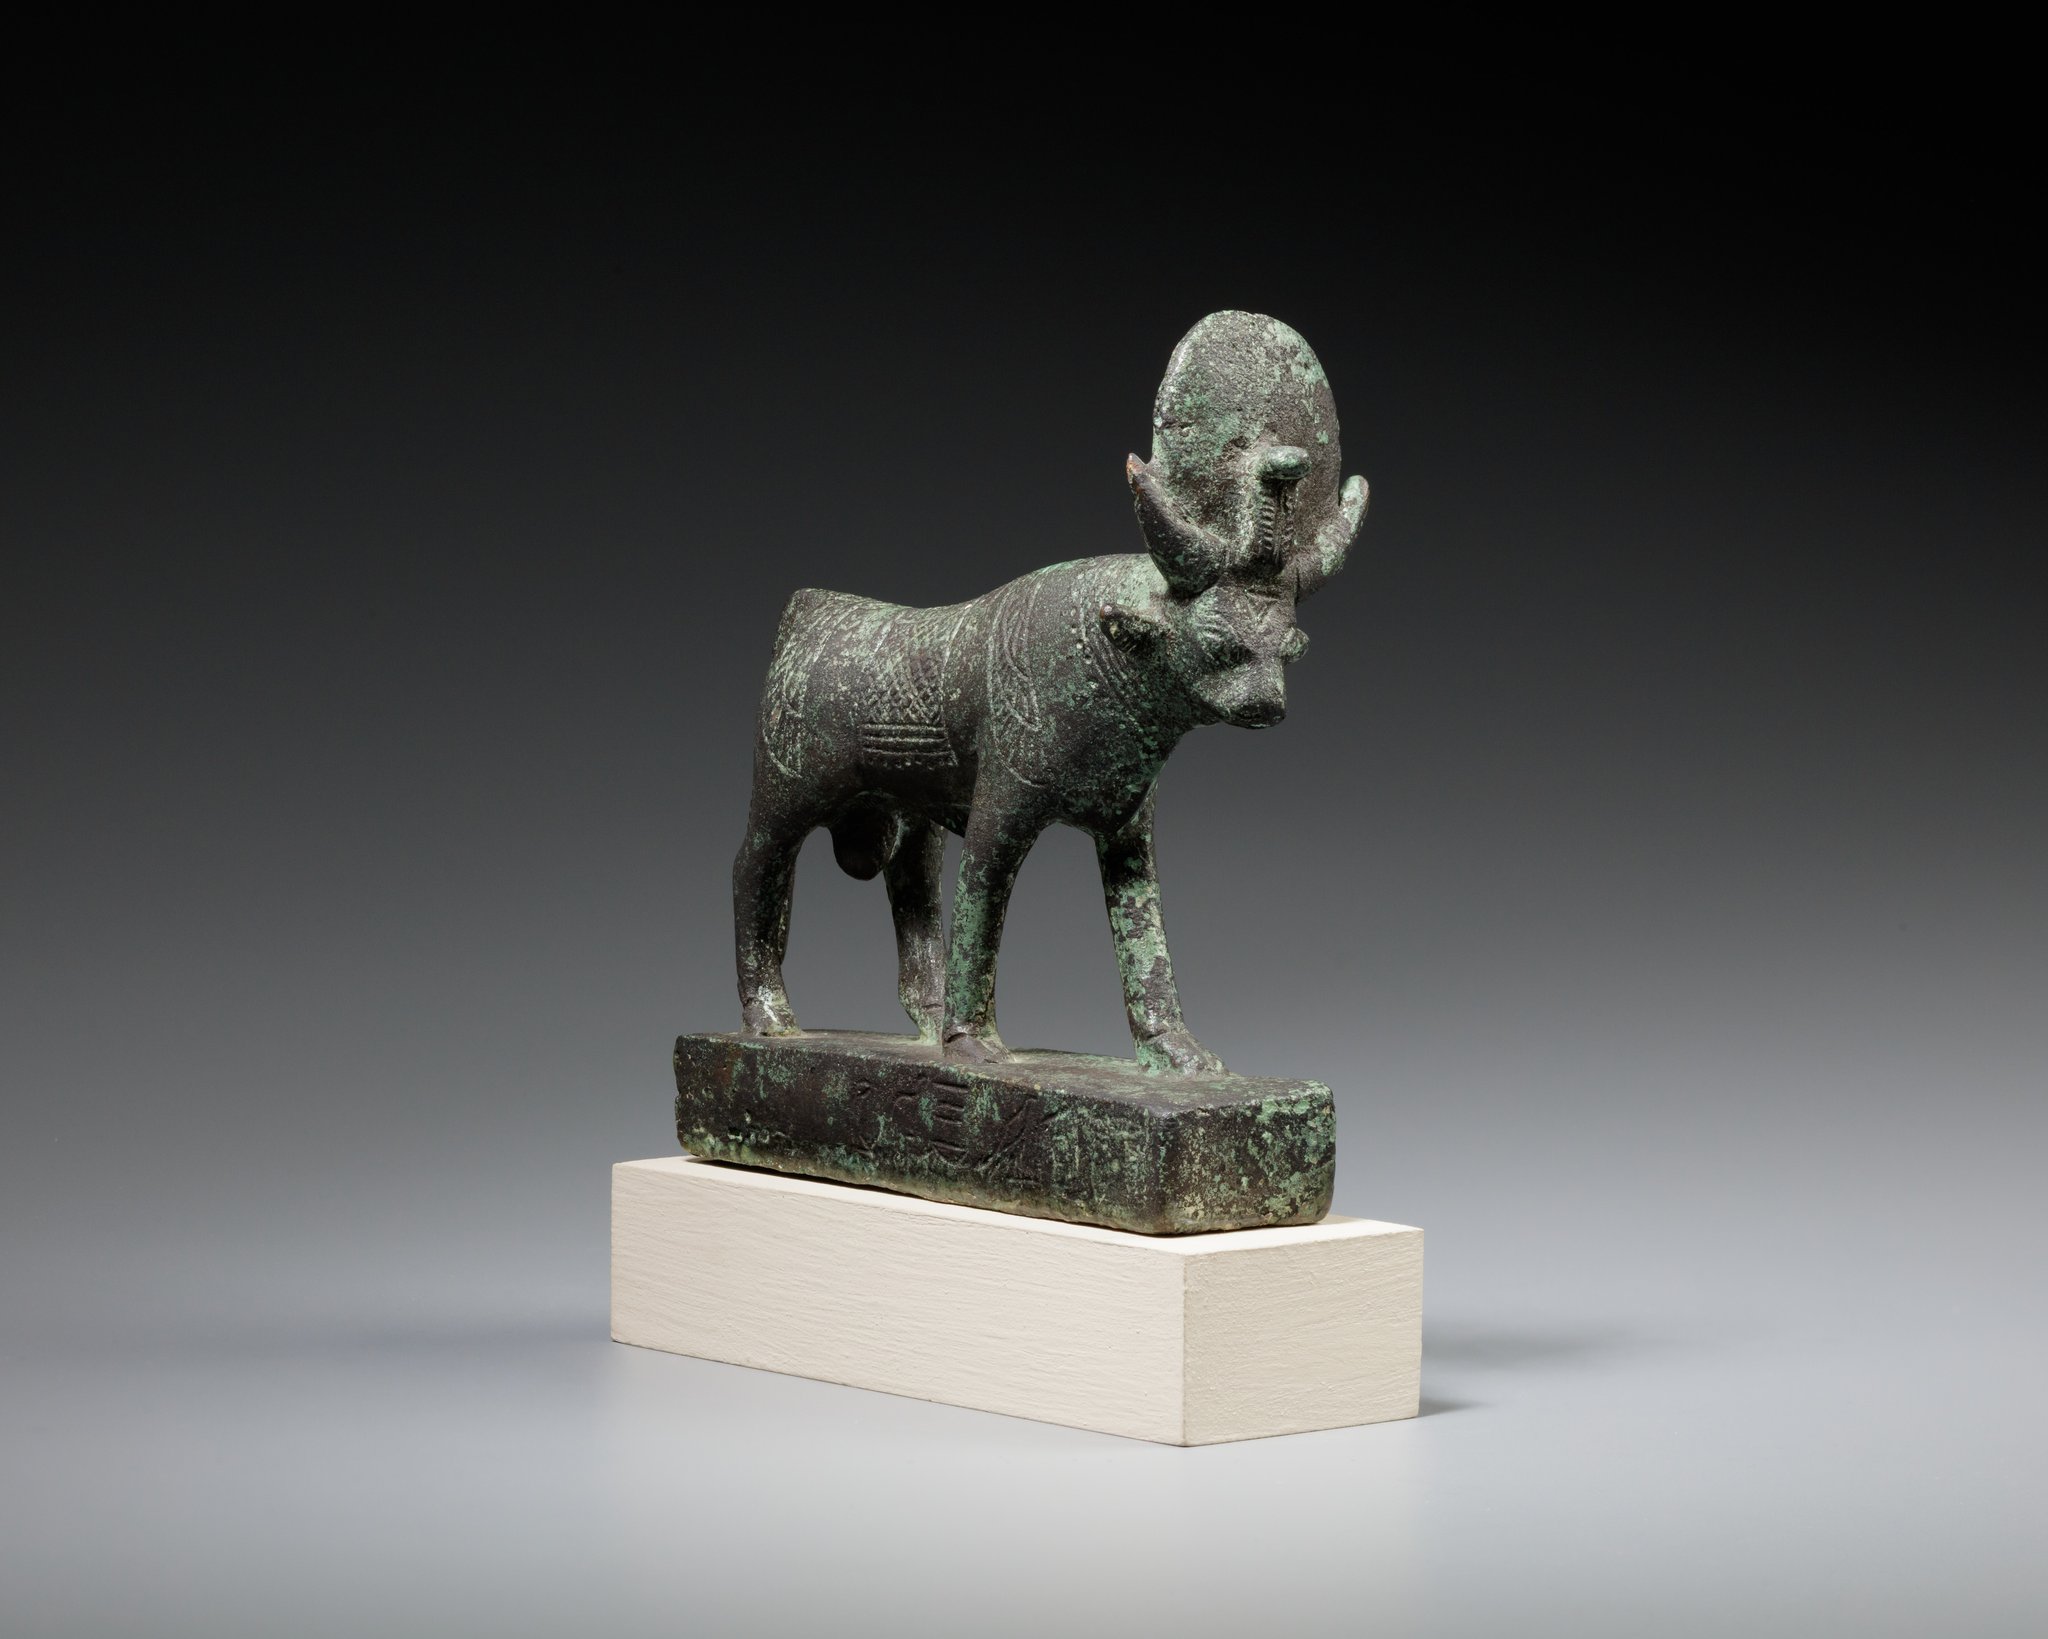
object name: figurine, apis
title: Apis, inscribed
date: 664-630 BCE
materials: metal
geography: egypt